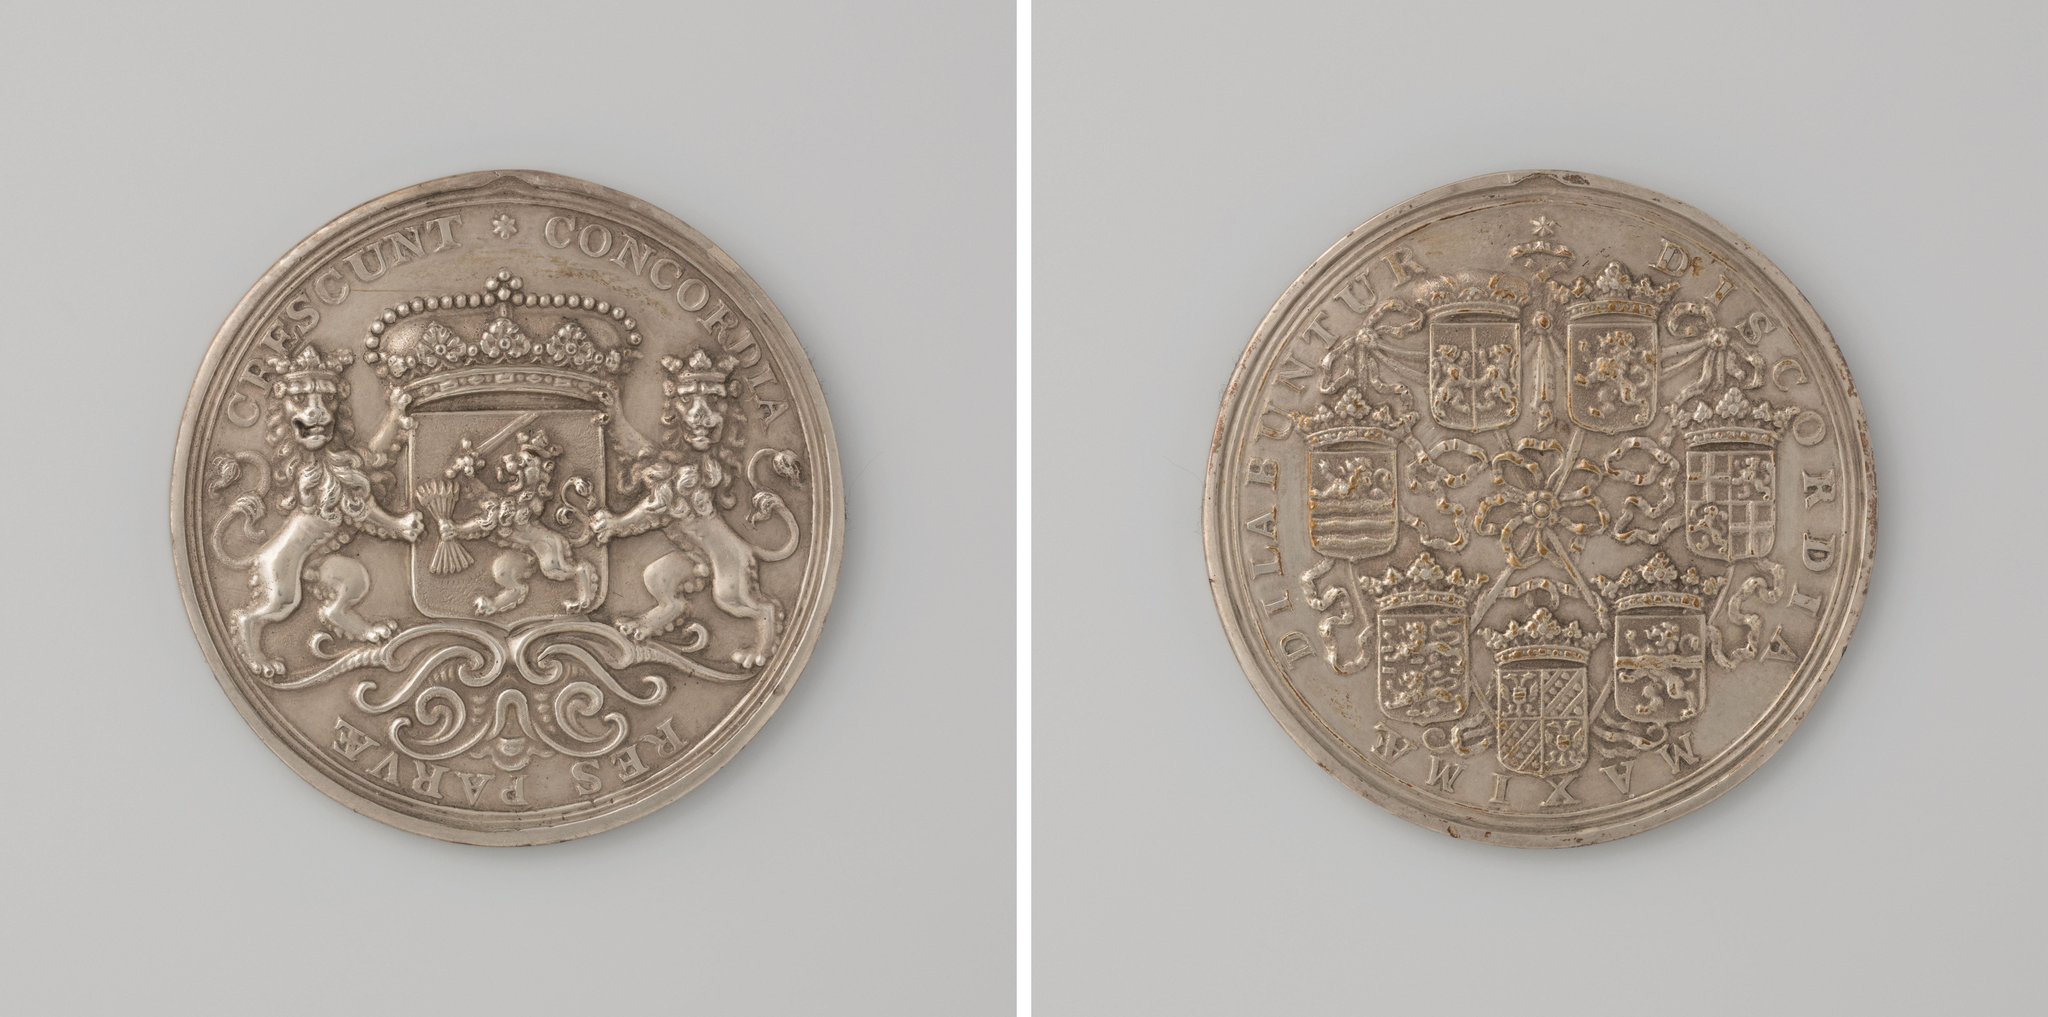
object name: beloningspenning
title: Beloningspenning van de Staten-Generaal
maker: nicolaas van swinderen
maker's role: jeweler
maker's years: 1705-1760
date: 1740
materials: silver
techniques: striking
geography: the hague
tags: netherlands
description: Zilveren penning. Voorzijde: gekroond wapenschild geflankeerd door twee gekroonde leeuwen binnen omschrift. Keerzijde: zeven met lint verbonden, gekroonde wapenschilden binnen omschrift.